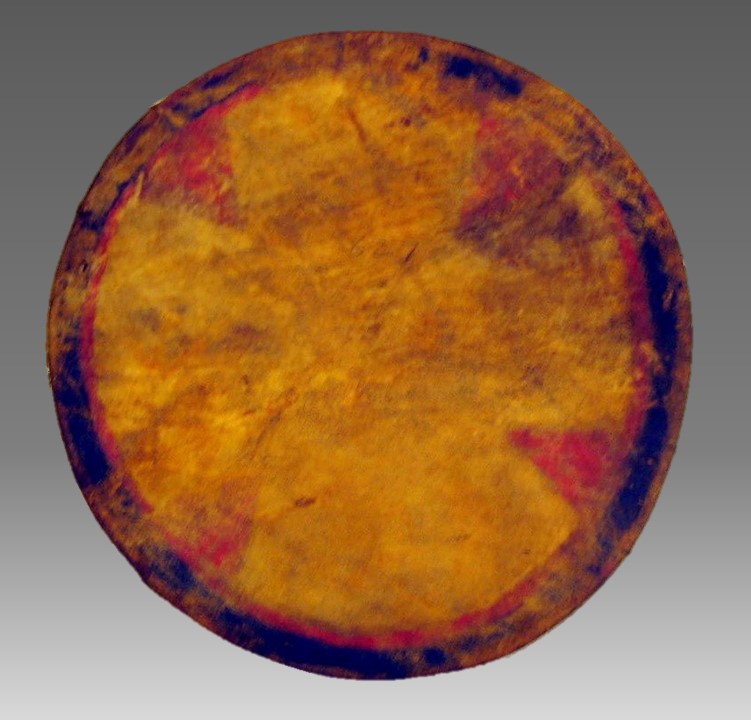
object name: frame drum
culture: native american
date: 1867-1900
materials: paint, wood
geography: united states